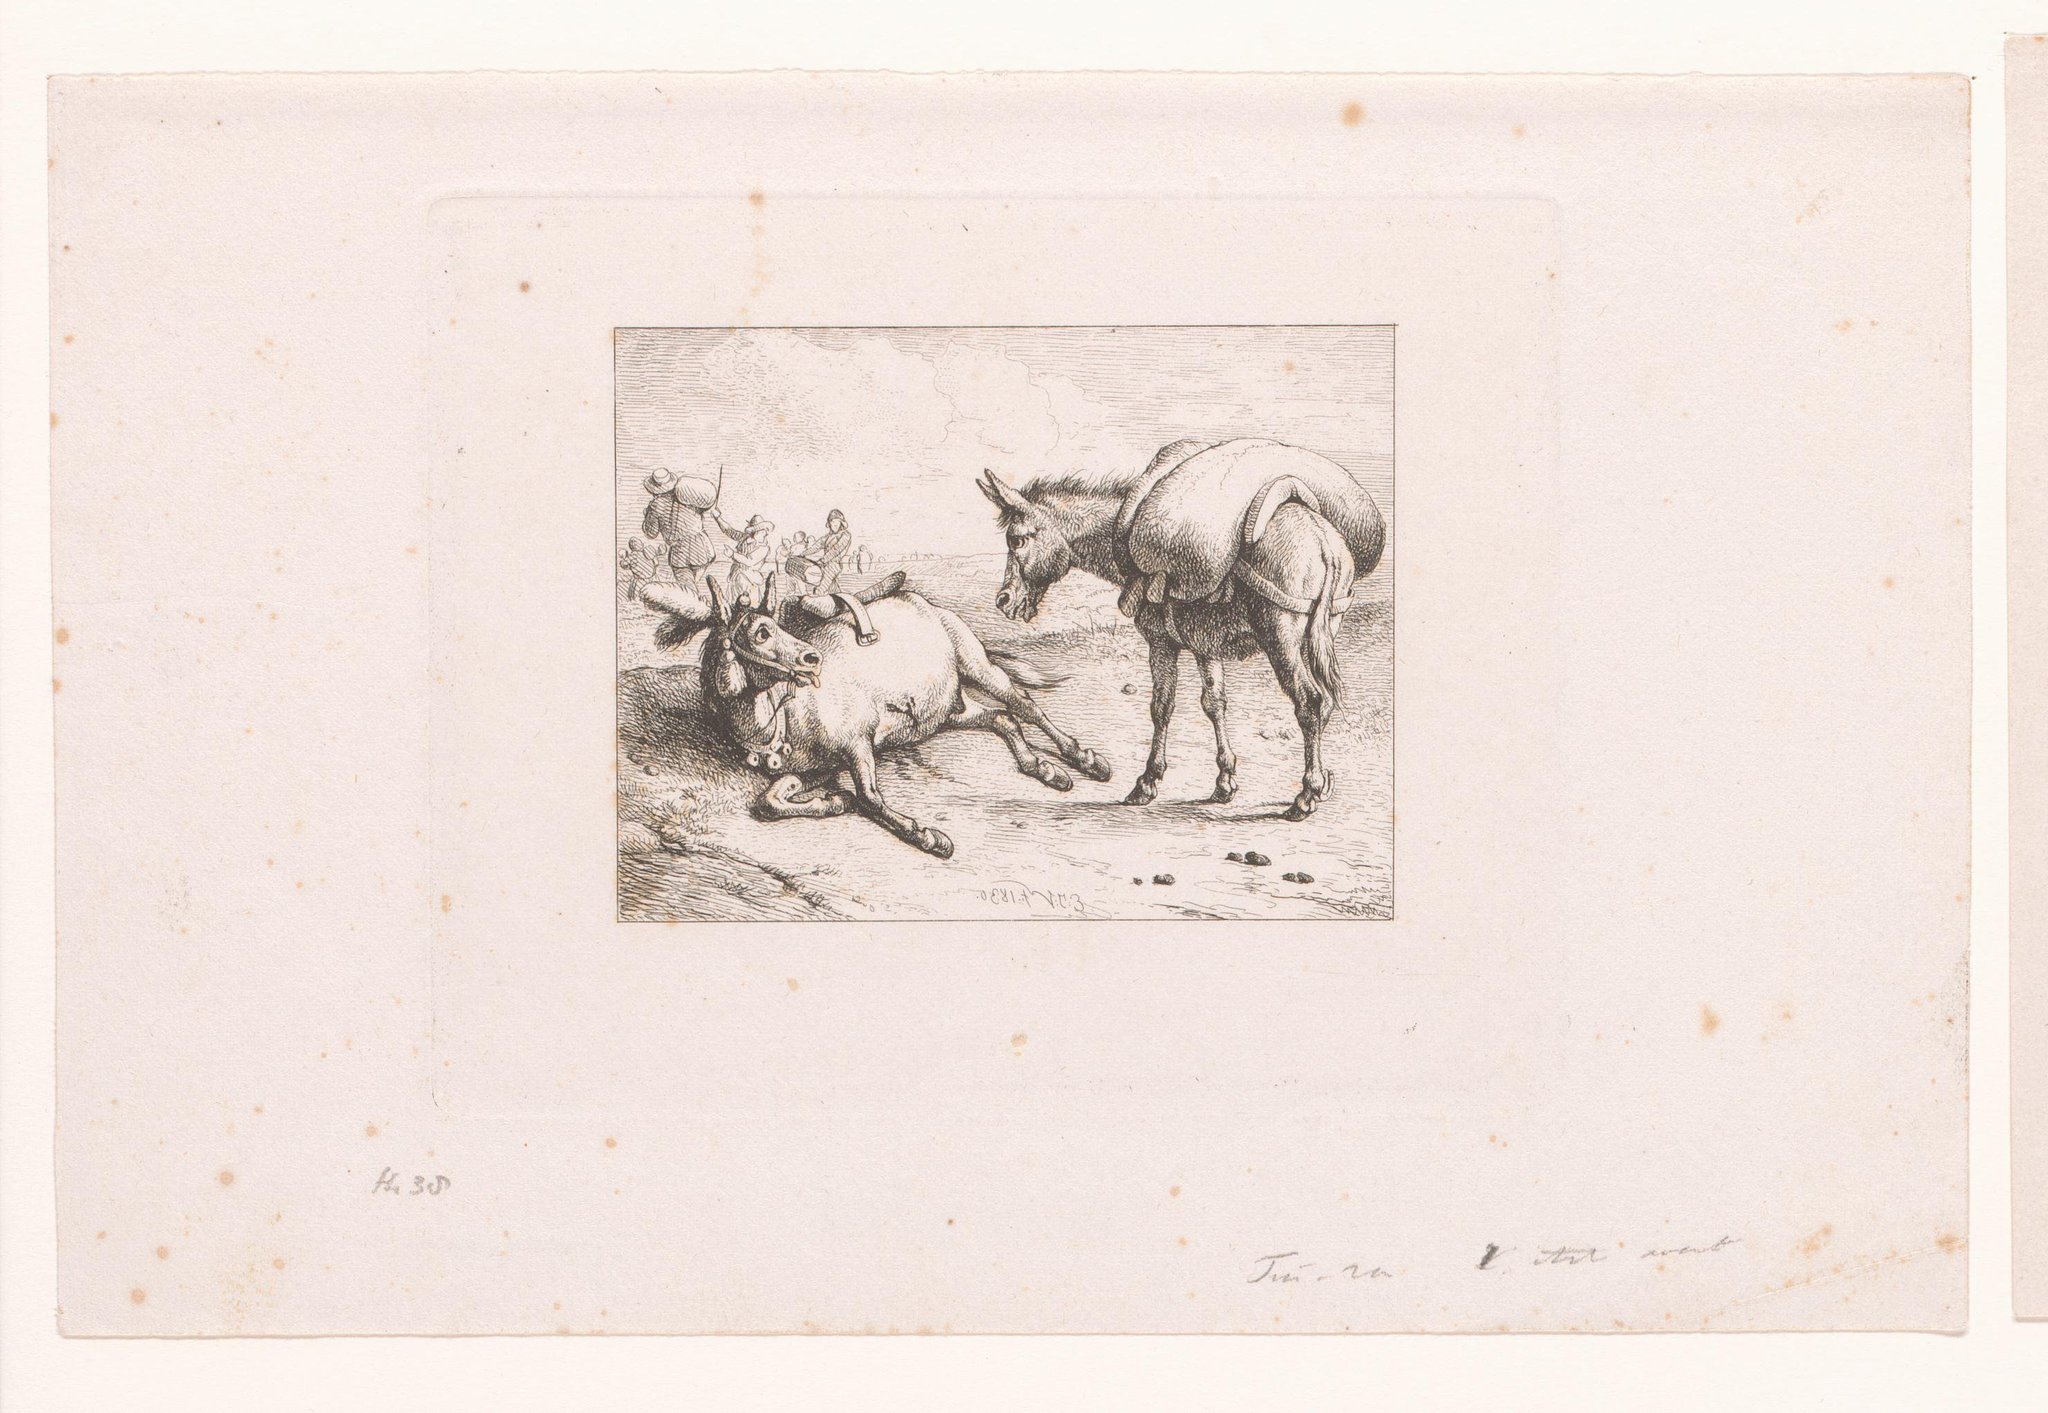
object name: print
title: Fabels van La Fontaine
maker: eugène verboeckhoven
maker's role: draughtsman, painter, print maker, printer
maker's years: 1798-1881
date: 1830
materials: paper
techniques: etching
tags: fables, mule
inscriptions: date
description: Prent maakt deel uit van een serie van acht prenten met scènes uit de fabels van Jean de La Fontaine.